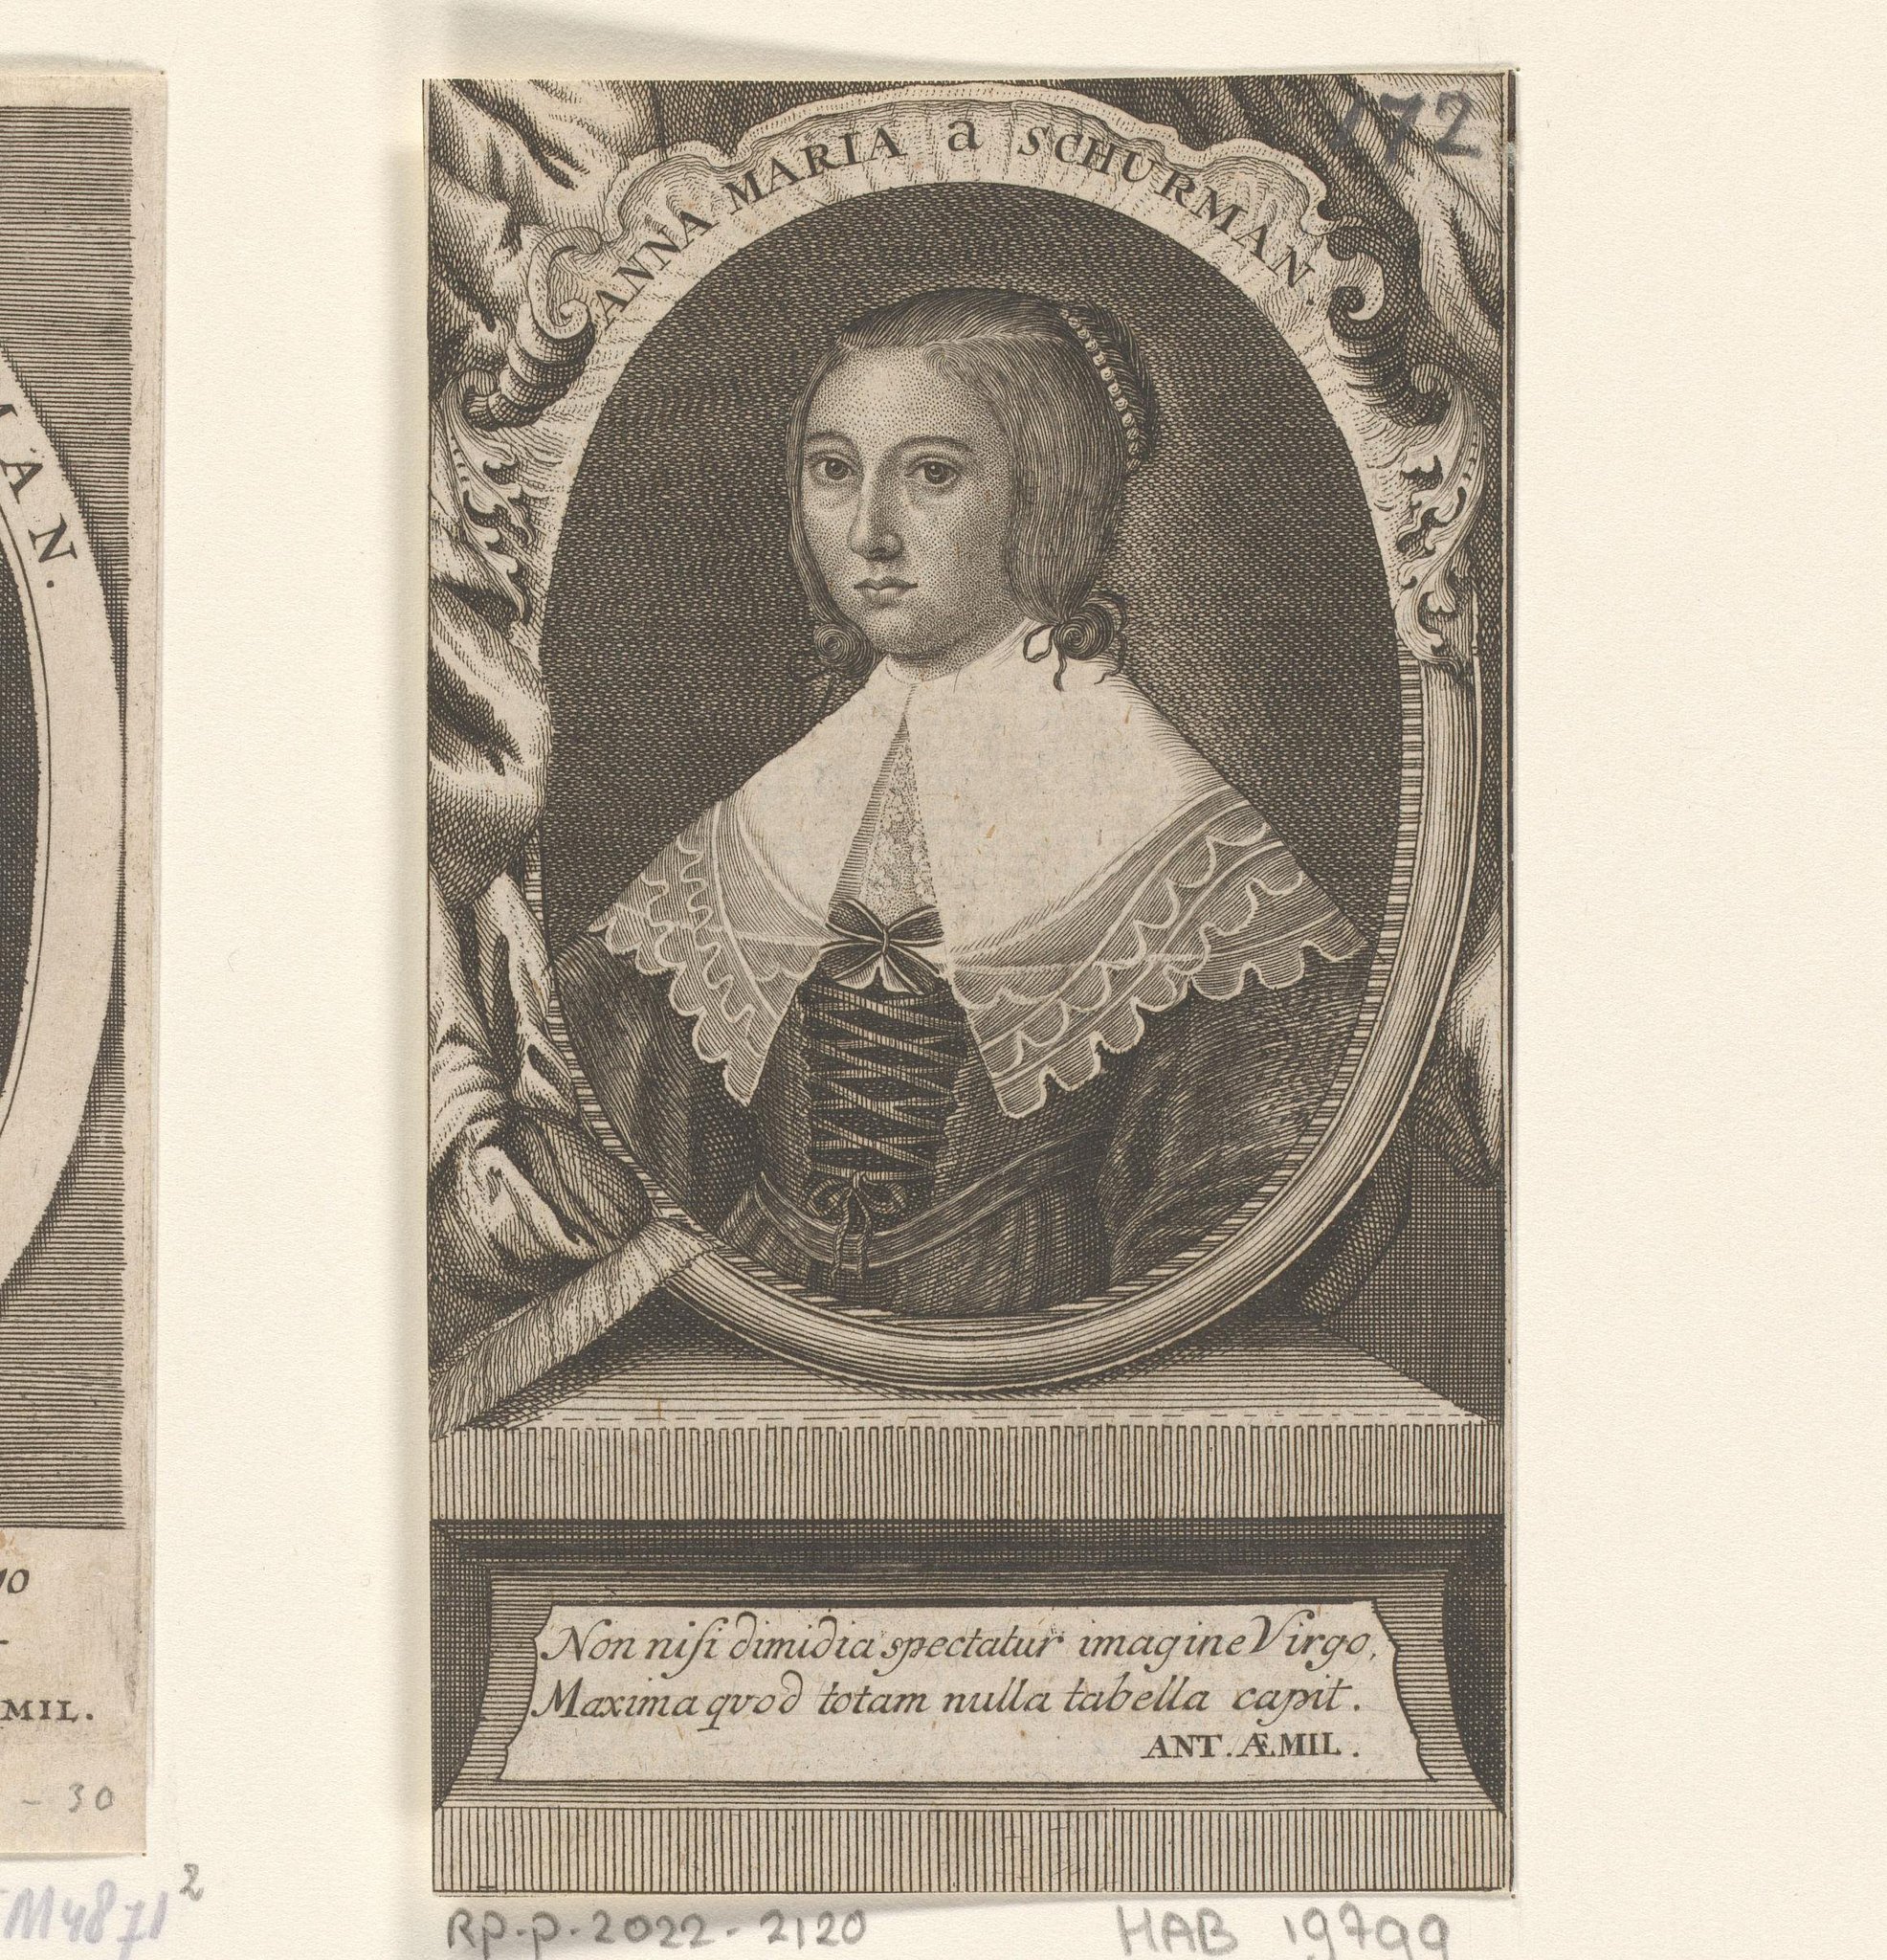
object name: print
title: Portret van Anna Maria van Schurman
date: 1713-1757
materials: paper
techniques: engraving, etching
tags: cologne, print maker, draughtsman, anna maria van schurman, historical persons - bb - woman, portrait, self-portrait of artist, writer, poet, author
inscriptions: number: ‘172’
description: Met tweeregelig onderschrift in het Latijn.